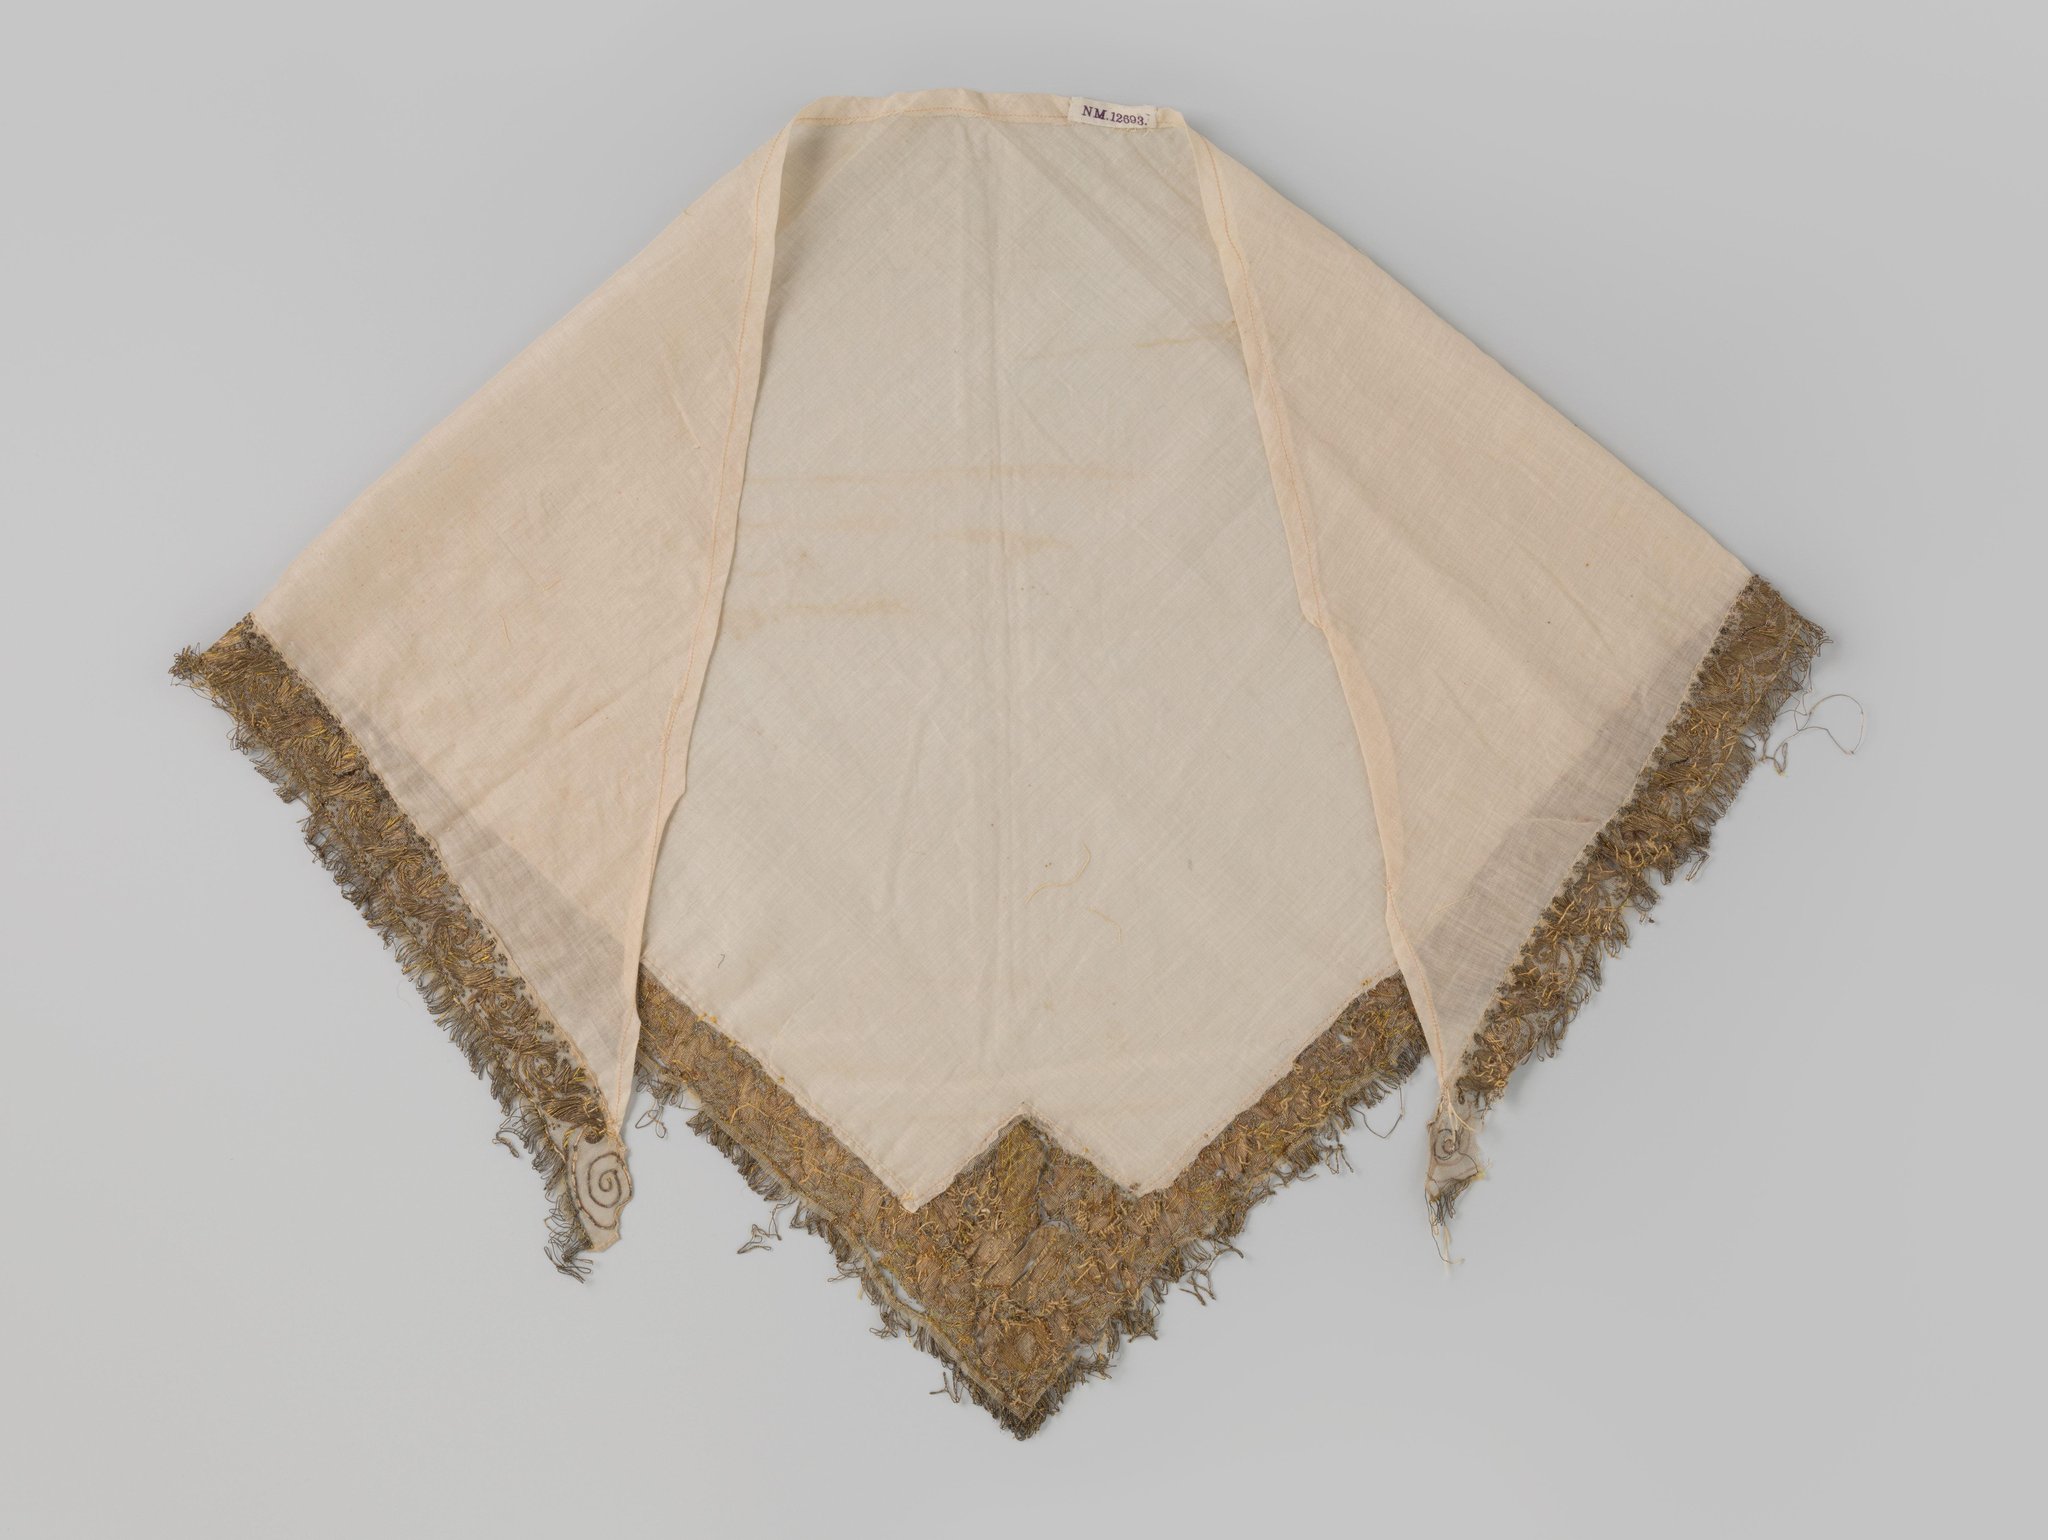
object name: fichu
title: Fichu van naturelkleurige zijde, driehoekig en langs twee zijden afgezet met passement van gouddraad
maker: Anonymous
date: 1740-1760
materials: gold thread, silk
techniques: embroidered, weave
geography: netherlands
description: Fichu van naturelkleurige zijde, driehoekig en langs twee zijden afgezet met passement van gouddraad. Model: langs twee zijden is met stiksteken (machinaal?) langs de onafgewerkt zijde een strook passement gezet. Aan de lange zijde is met onregelmatige stiksteken een zoom vastgezet. Versiering: in de punt een gestapeld ornament met blad- en bloemmotieven. Het passement is afgezet met een franje van gesloten lussen.